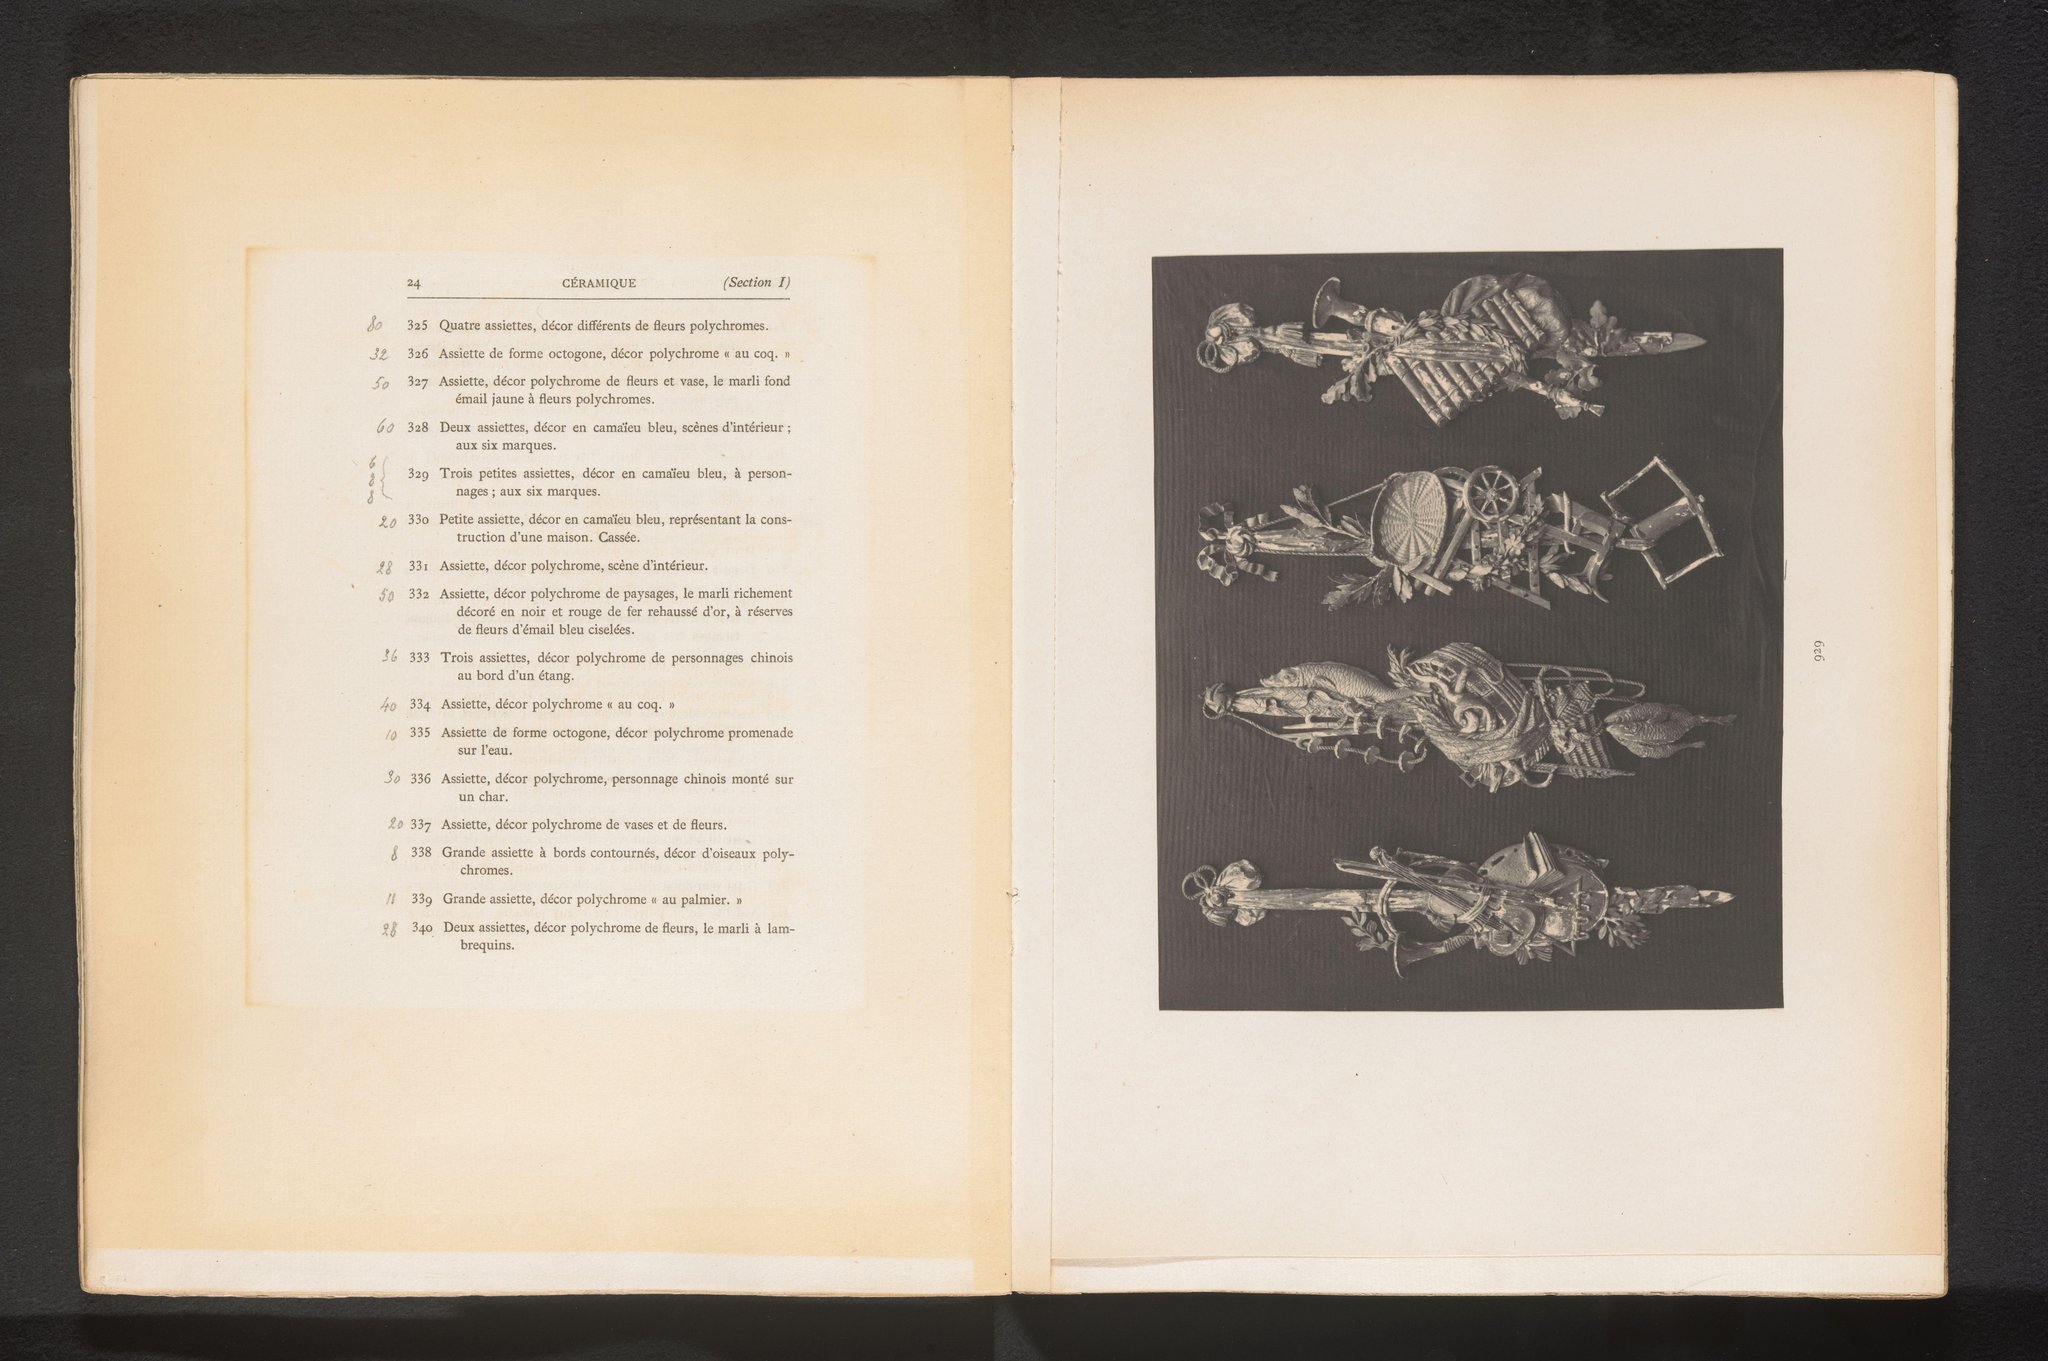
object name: photograph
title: Vier kleine trofeeën van muziek, vis en landbouw in verguld hout uit de collectie van Antonin Terme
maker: Anonymous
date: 1880-1885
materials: photographic support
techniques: platinum process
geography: liège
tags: art collection, art gallery, trophy, i.e.: decorative arrangement of symbolic or typical objects ~ ornament